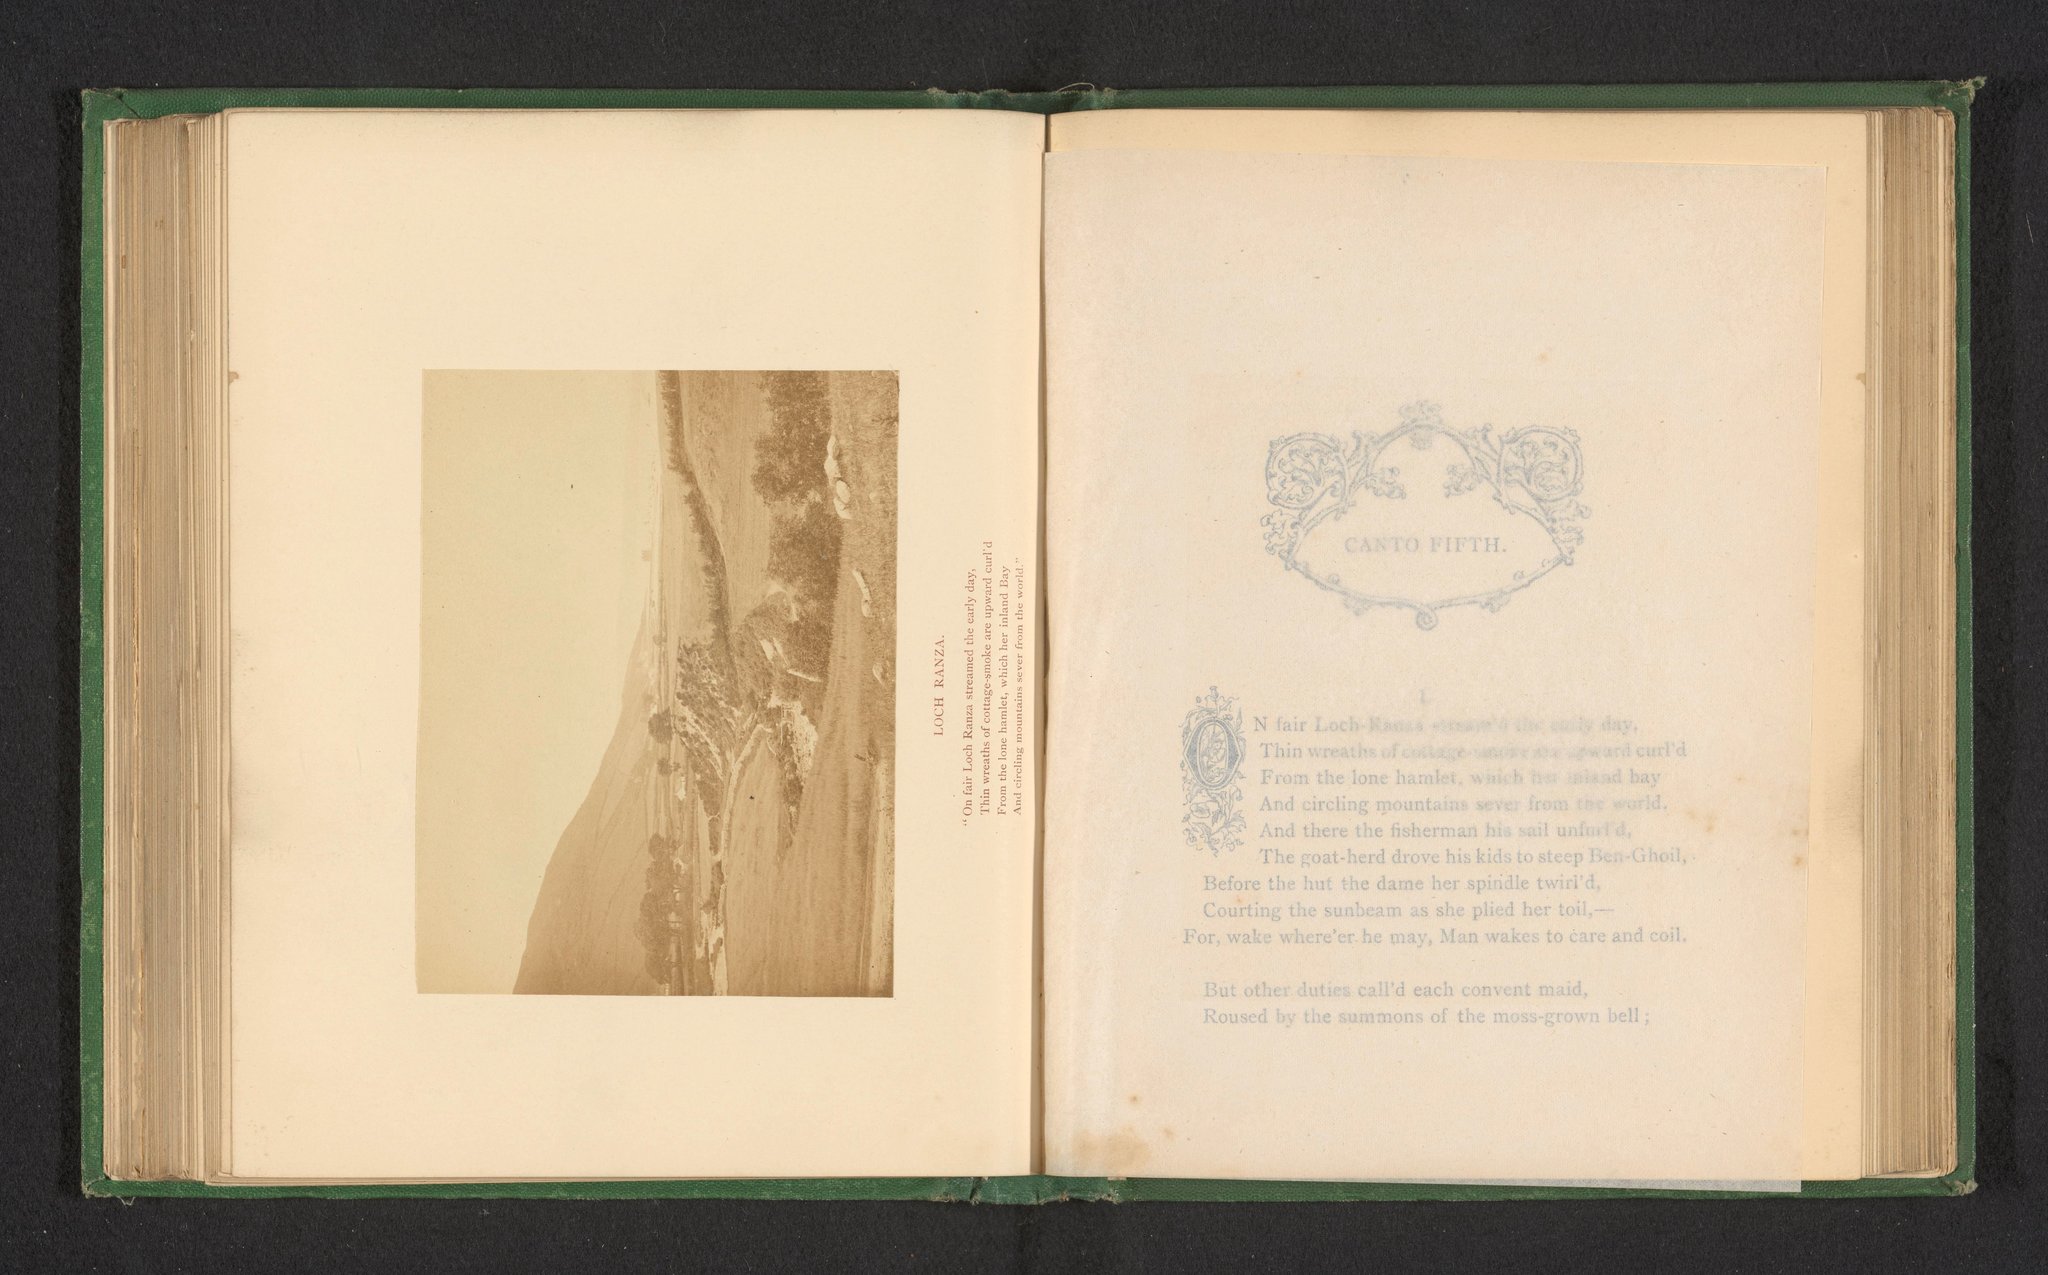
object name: page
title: Loch Ranza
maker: william russell sedgfield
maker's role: fotograaf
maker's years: 1826-1902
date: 1861-1871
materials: photographic support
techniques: albumen print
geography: arran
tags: lake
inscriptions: inscription: ‘"On fair (...) the world."’